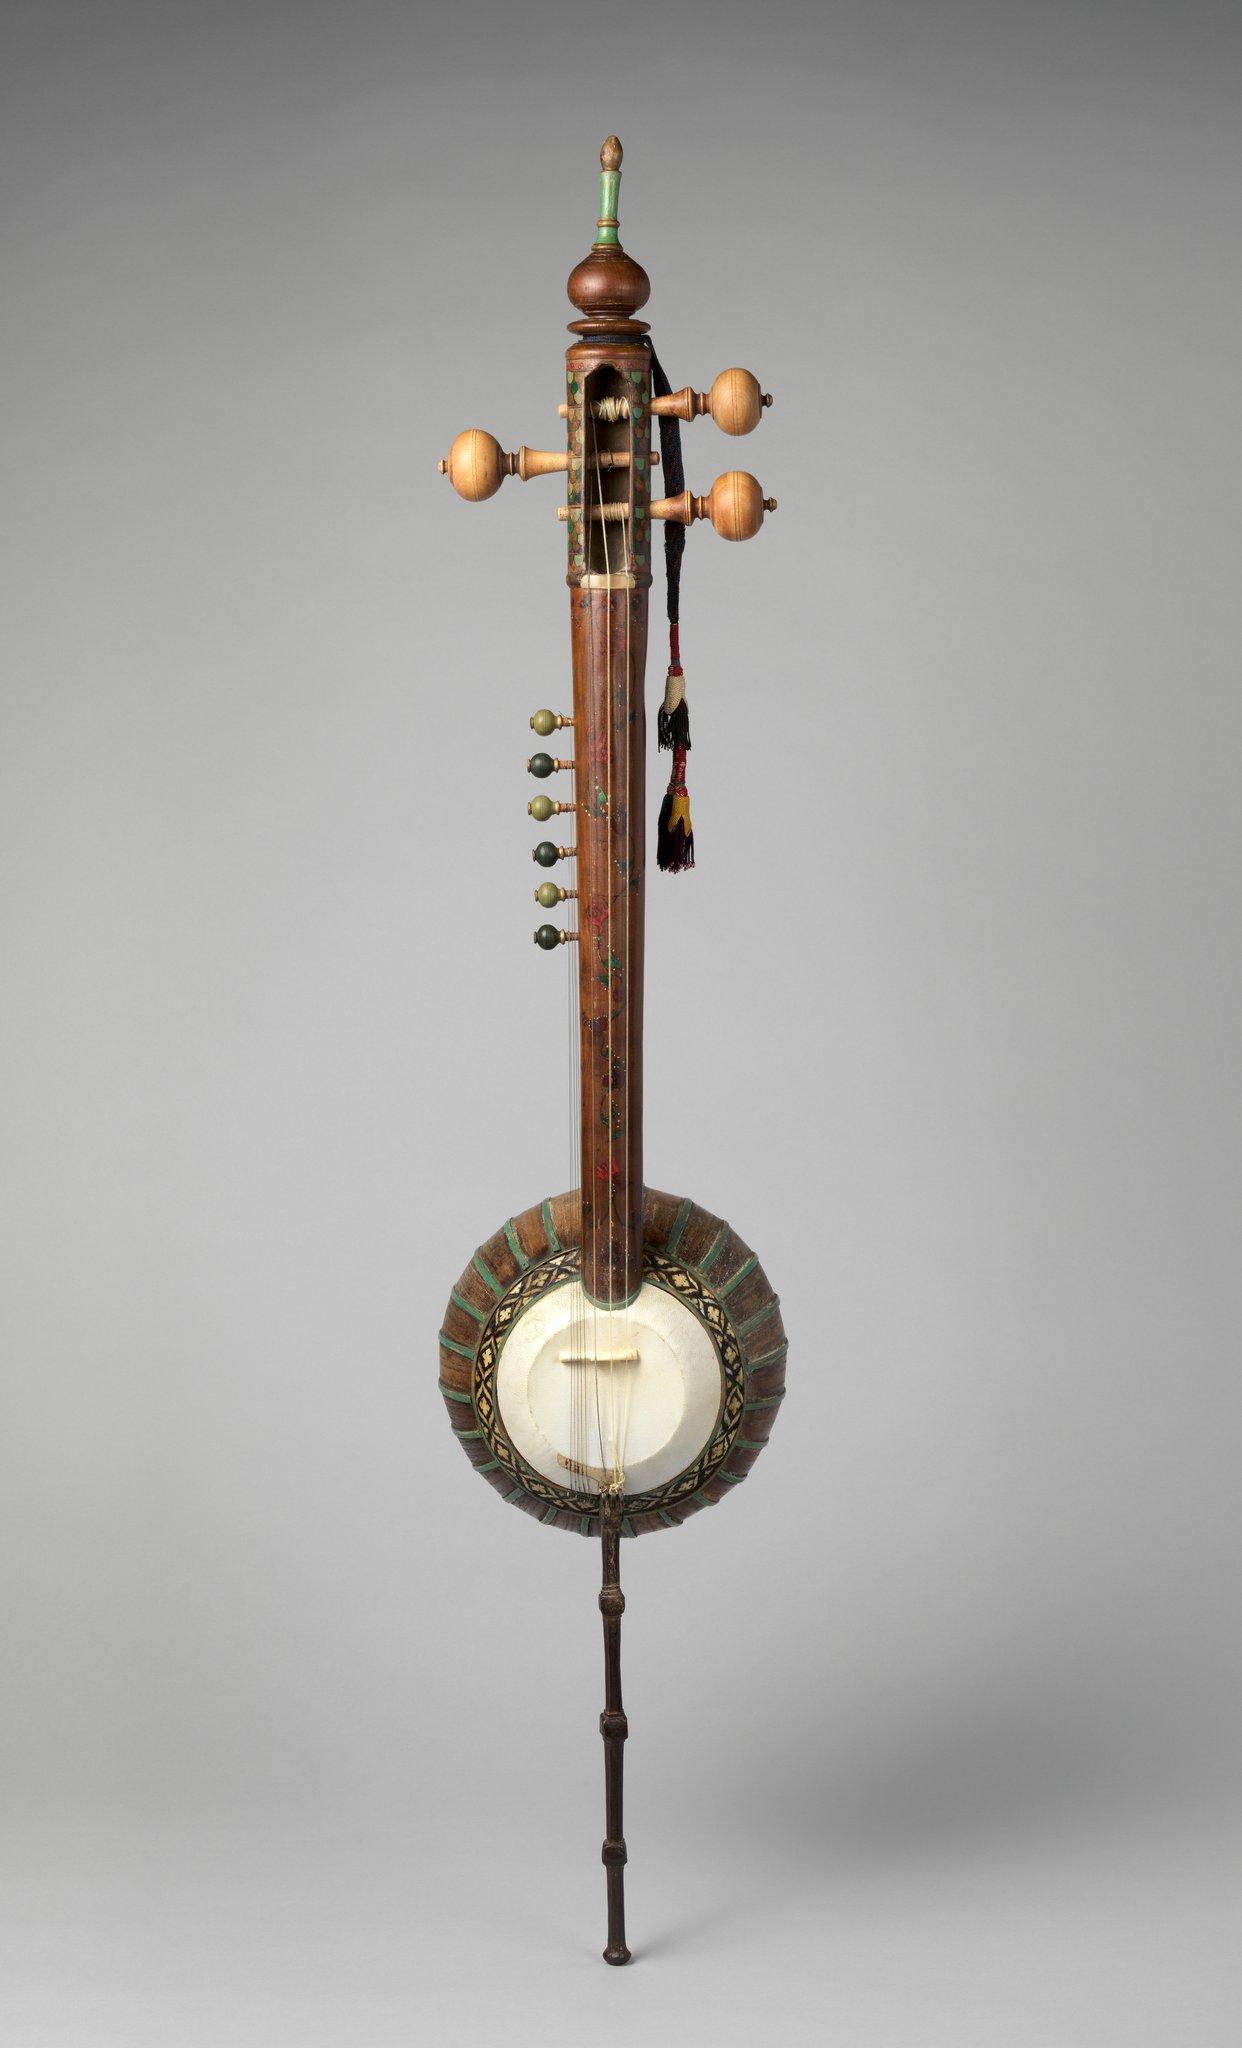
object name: sāz ī kāshmīr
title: Sāz-ī-Kāshmīr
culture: kashmiri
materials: textile, iron, metal, plastic, skin, wood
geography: pakistan